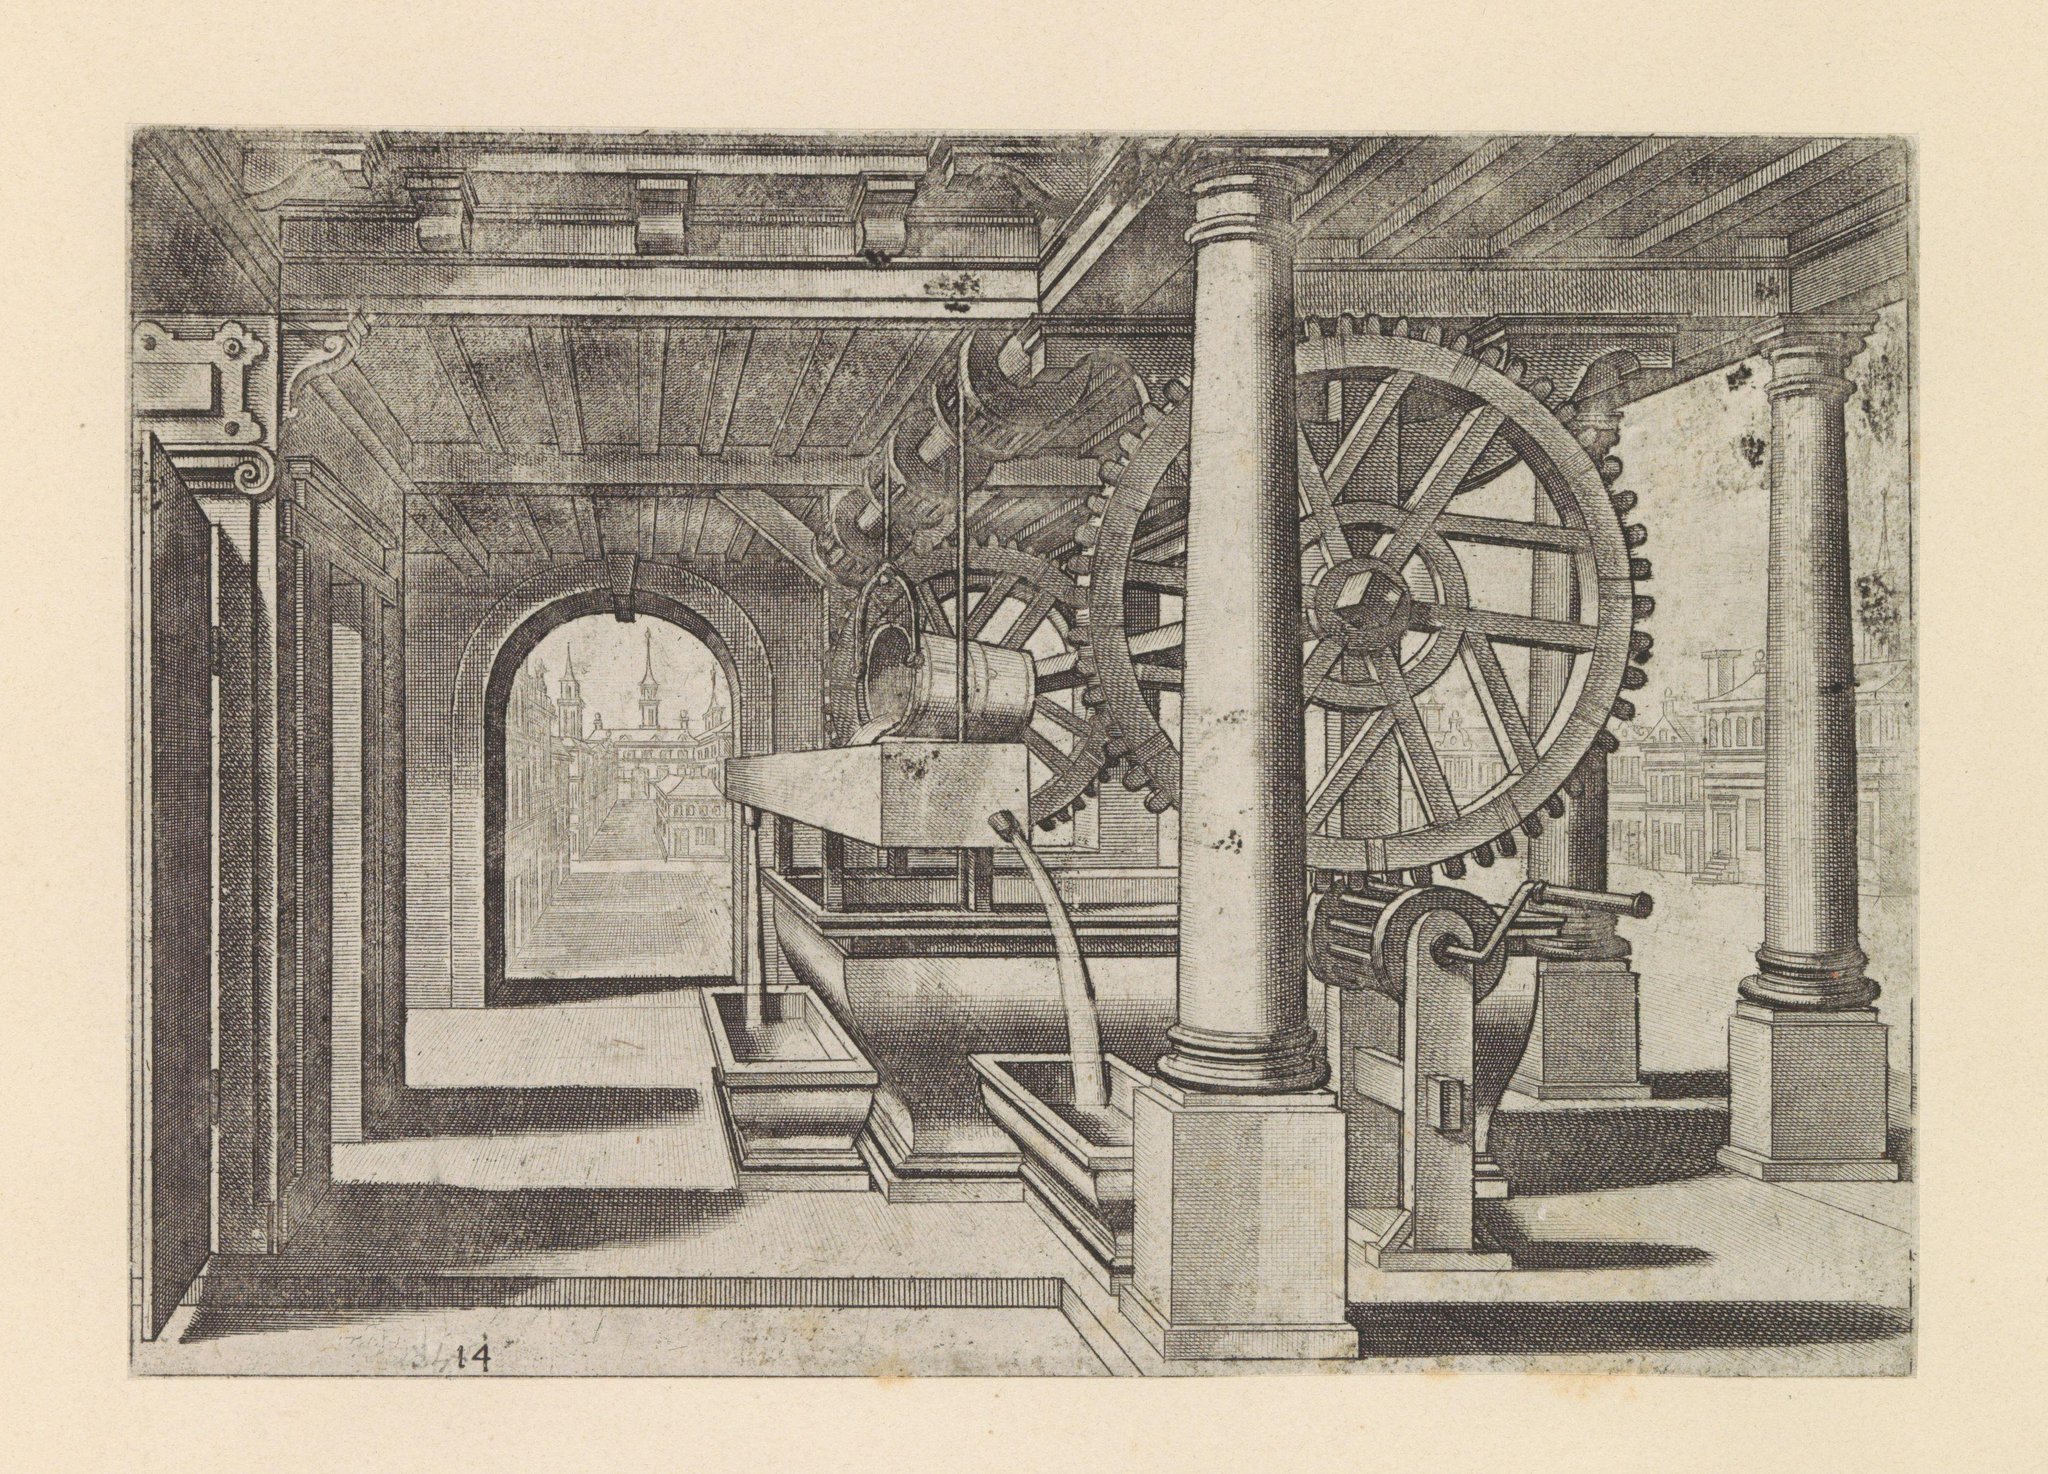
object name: album leaf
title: Waterput onder colonnade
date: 1574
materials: paper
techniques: etching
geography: antwerp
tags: well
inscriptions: inscription: ‘34’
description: Onder een colonnade staat een watersysteem met kolossale tandwielen en een houten vat dat het water in een rechthoekig bassin giet. Op de achtergrond een gezicht op een groot stadsplein. De prent maakt deel uit van een album.